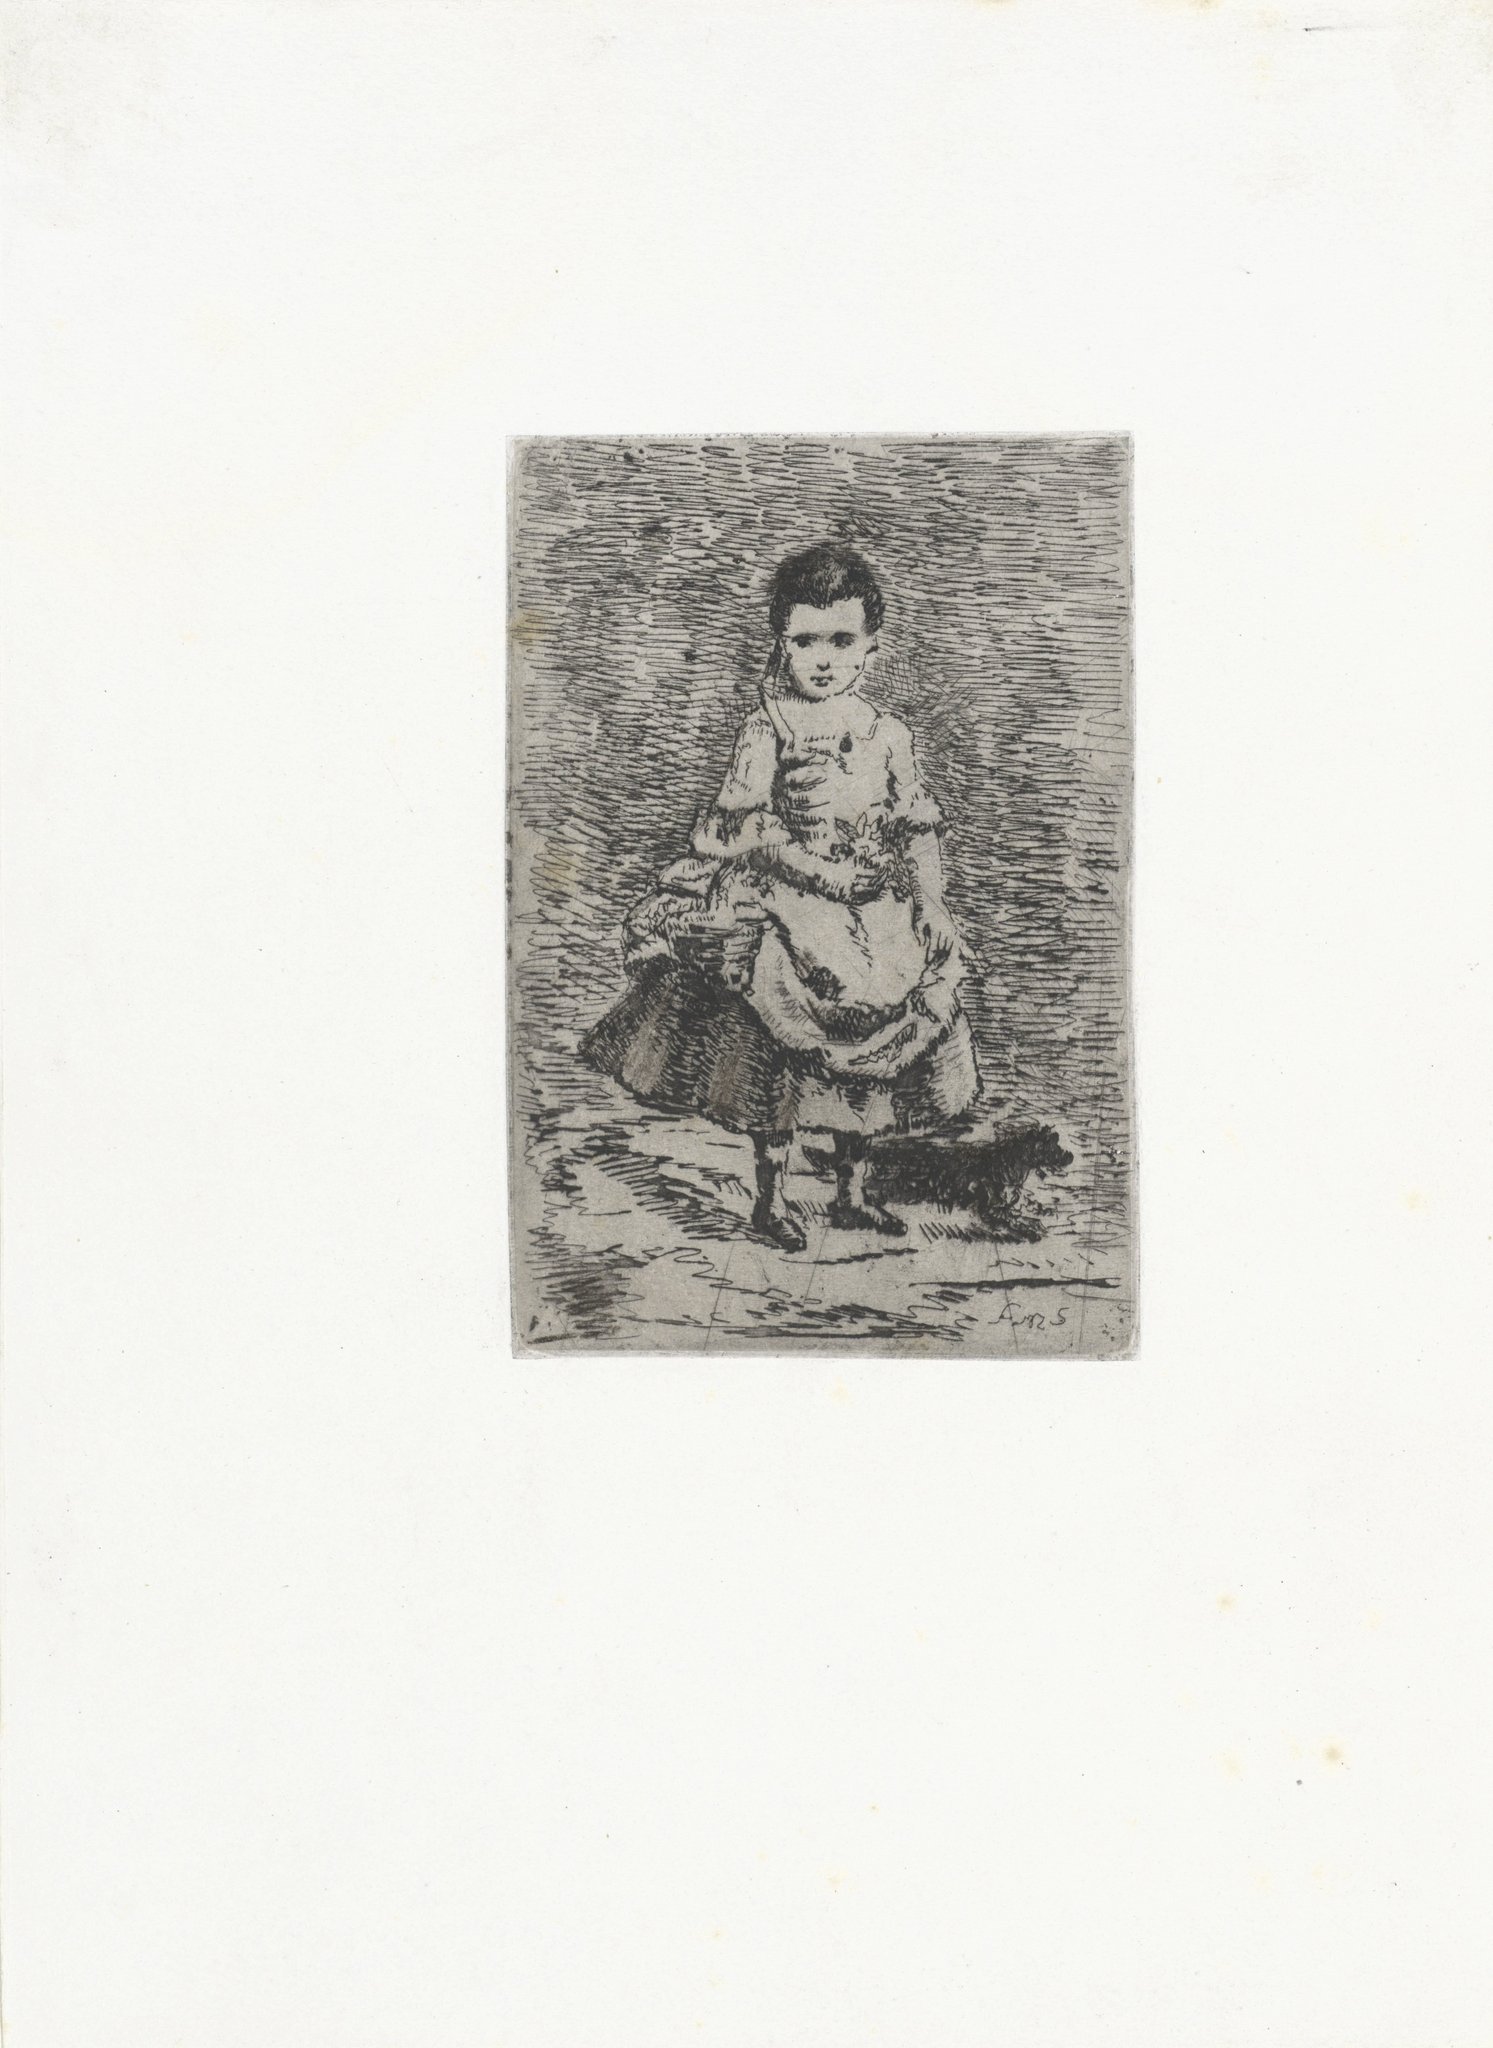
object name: print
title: Jong meisje met hond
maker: arnoud schaepkens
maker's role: print maker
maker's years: 1816-1904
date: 1831-1904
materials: paper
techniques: drypoint, etching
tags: girl (child between toddler and youth), dog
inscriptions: collector's mark: Lugt 2228